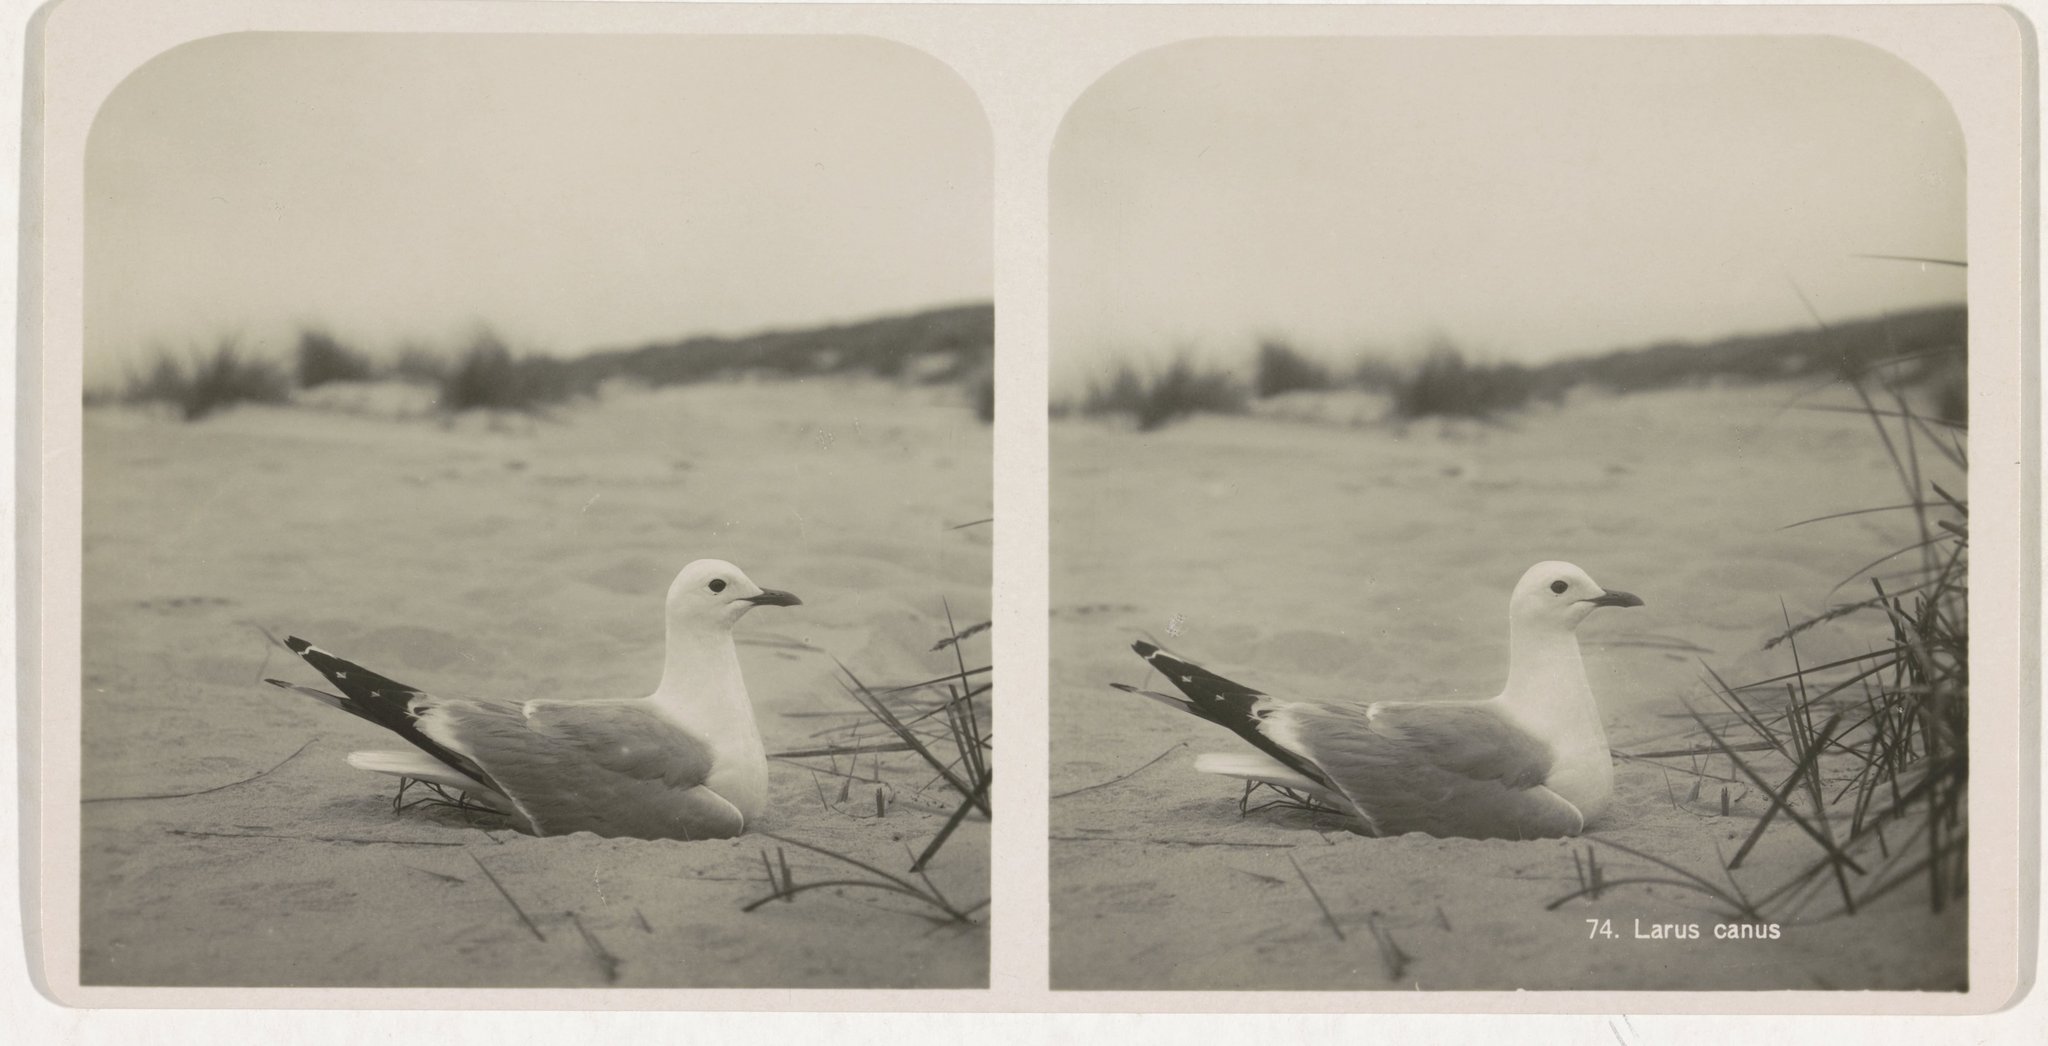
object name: photograph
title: 74. Larus canus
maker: adolphe burdet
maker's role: fotograaf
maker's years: 1860-1940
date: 1870-1940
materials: photographic support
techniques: gelatin silver print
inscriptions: label: ‘Meeuw.’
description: De foto maakt deel uit van een serie van 12 stereofoto's, bewaard in het originele mapje. De foto's tonen zeevogels in natuurgebied De Bol op Texel.